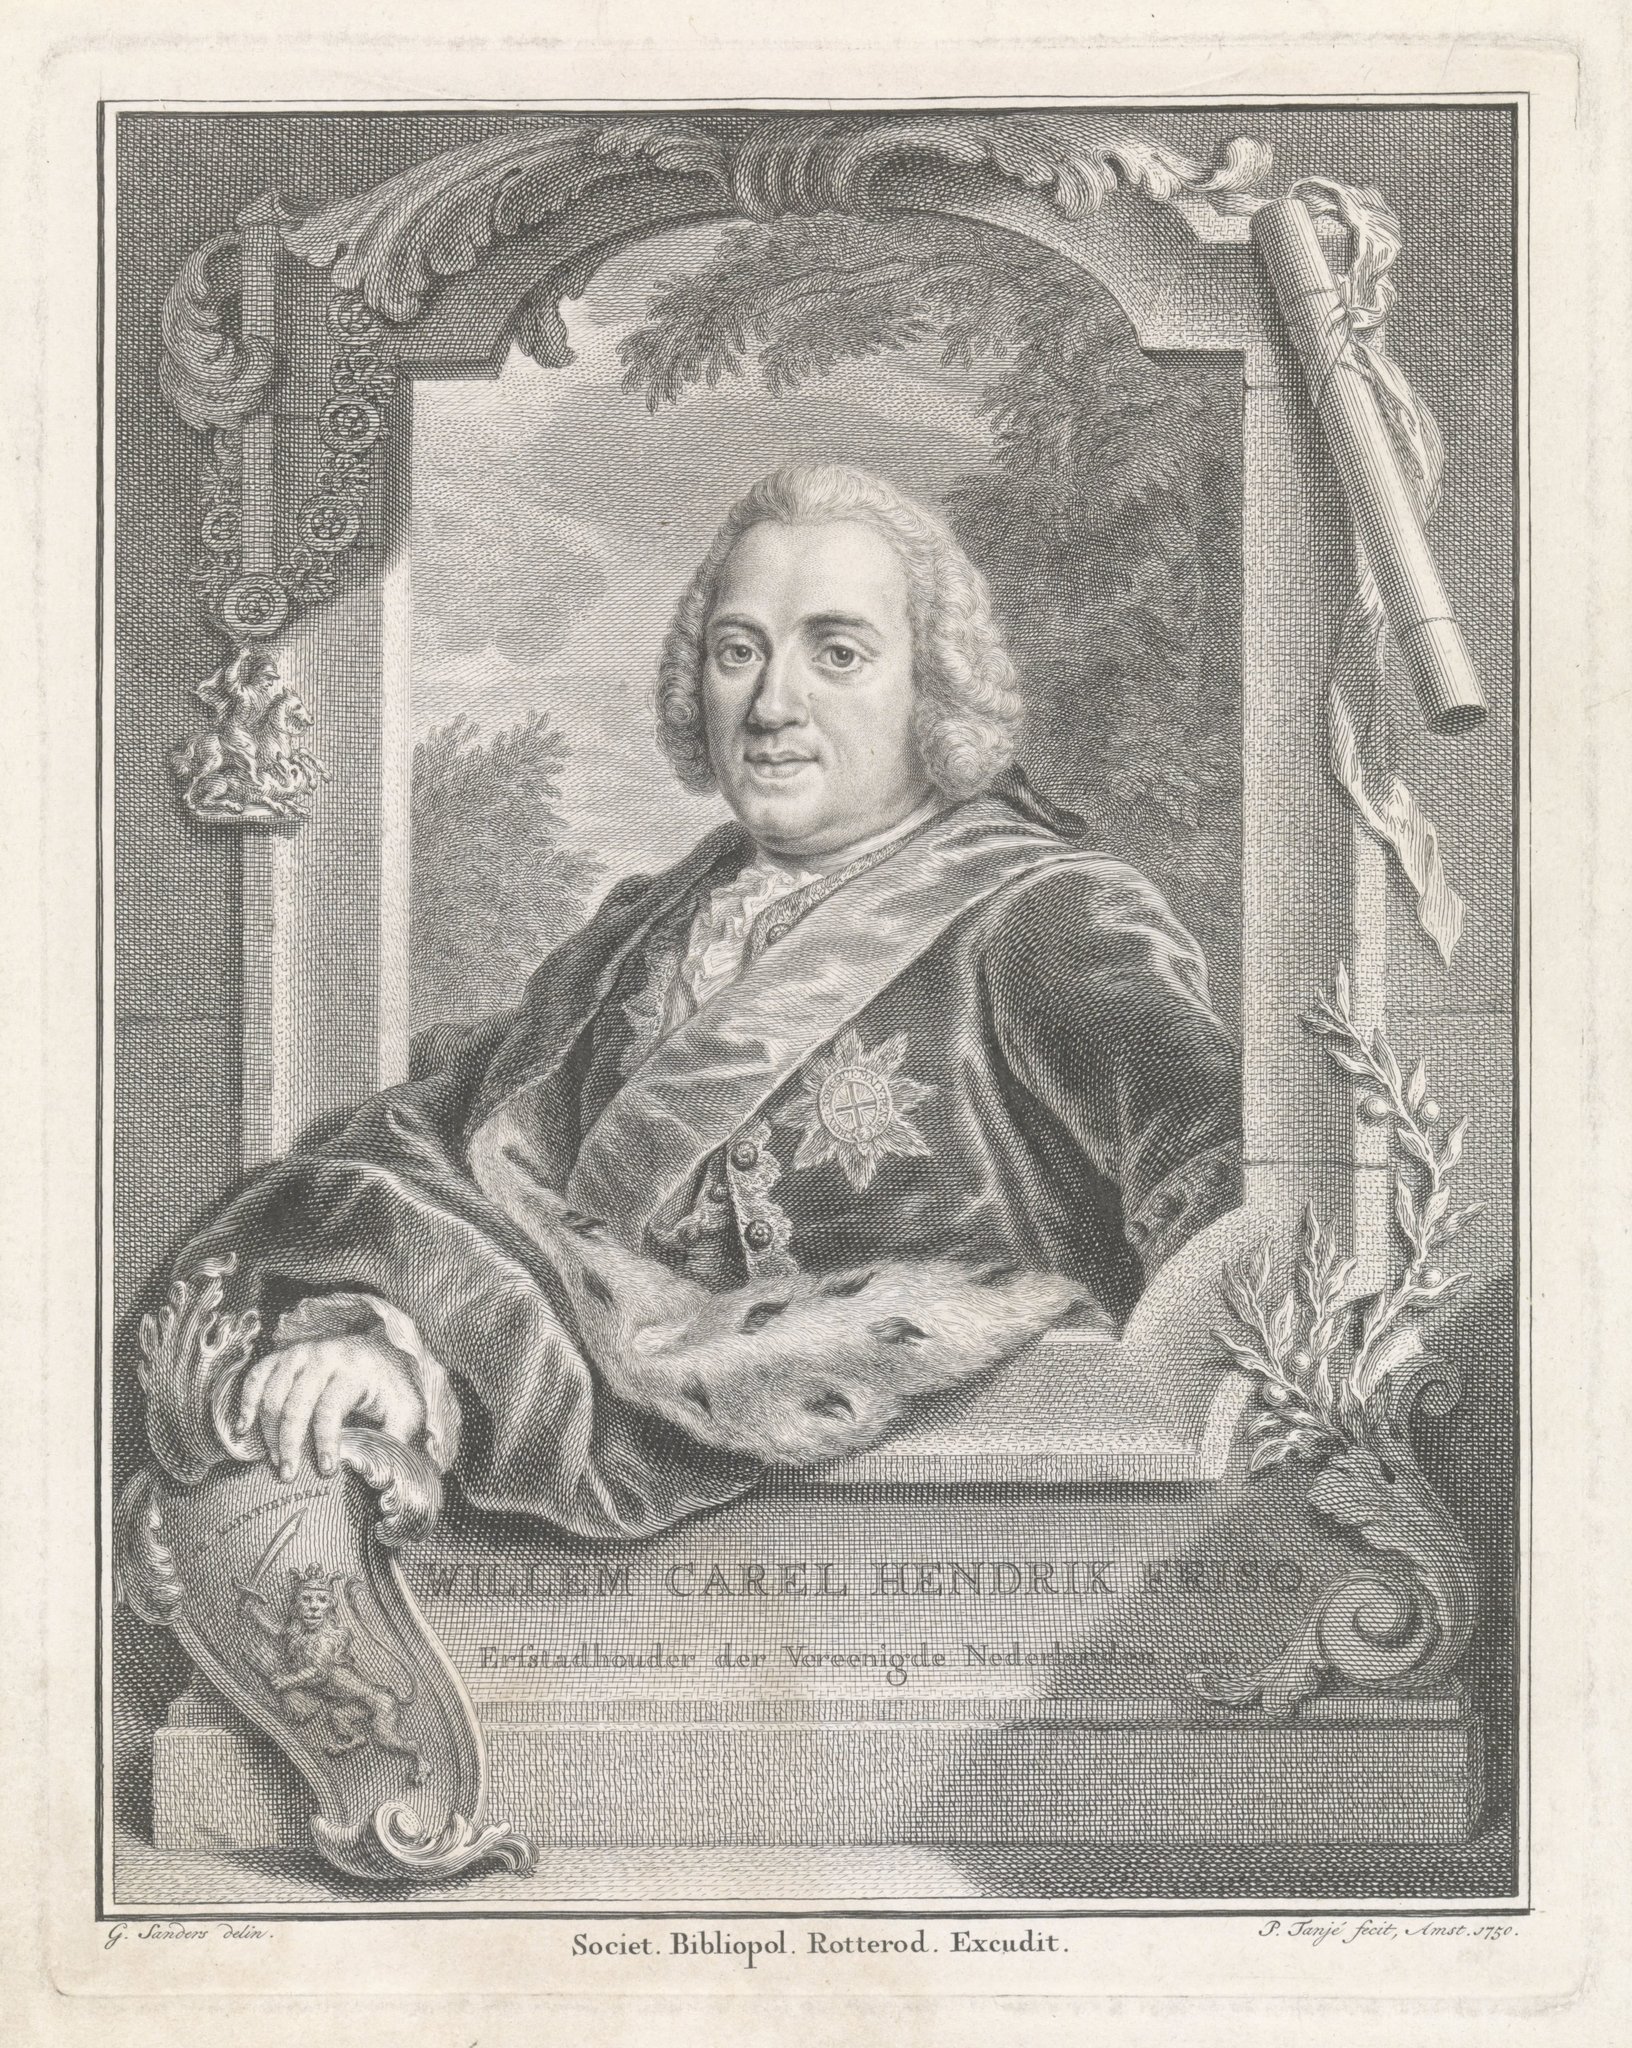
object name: print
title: Portret van prins Willem IV van Oranje-Nassau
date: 1750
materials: paper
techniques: engraving, etching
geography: amsterdam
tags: willem iv (prins van oranje-nassau)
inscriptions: collector's mark: Lugt 2228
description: Willem IV, prins van Oranje-Nassau en stadhouder, gezien door een venster, met een hermelijnen mantel over een schouder. Hij toont het Nederlands wapenschild.